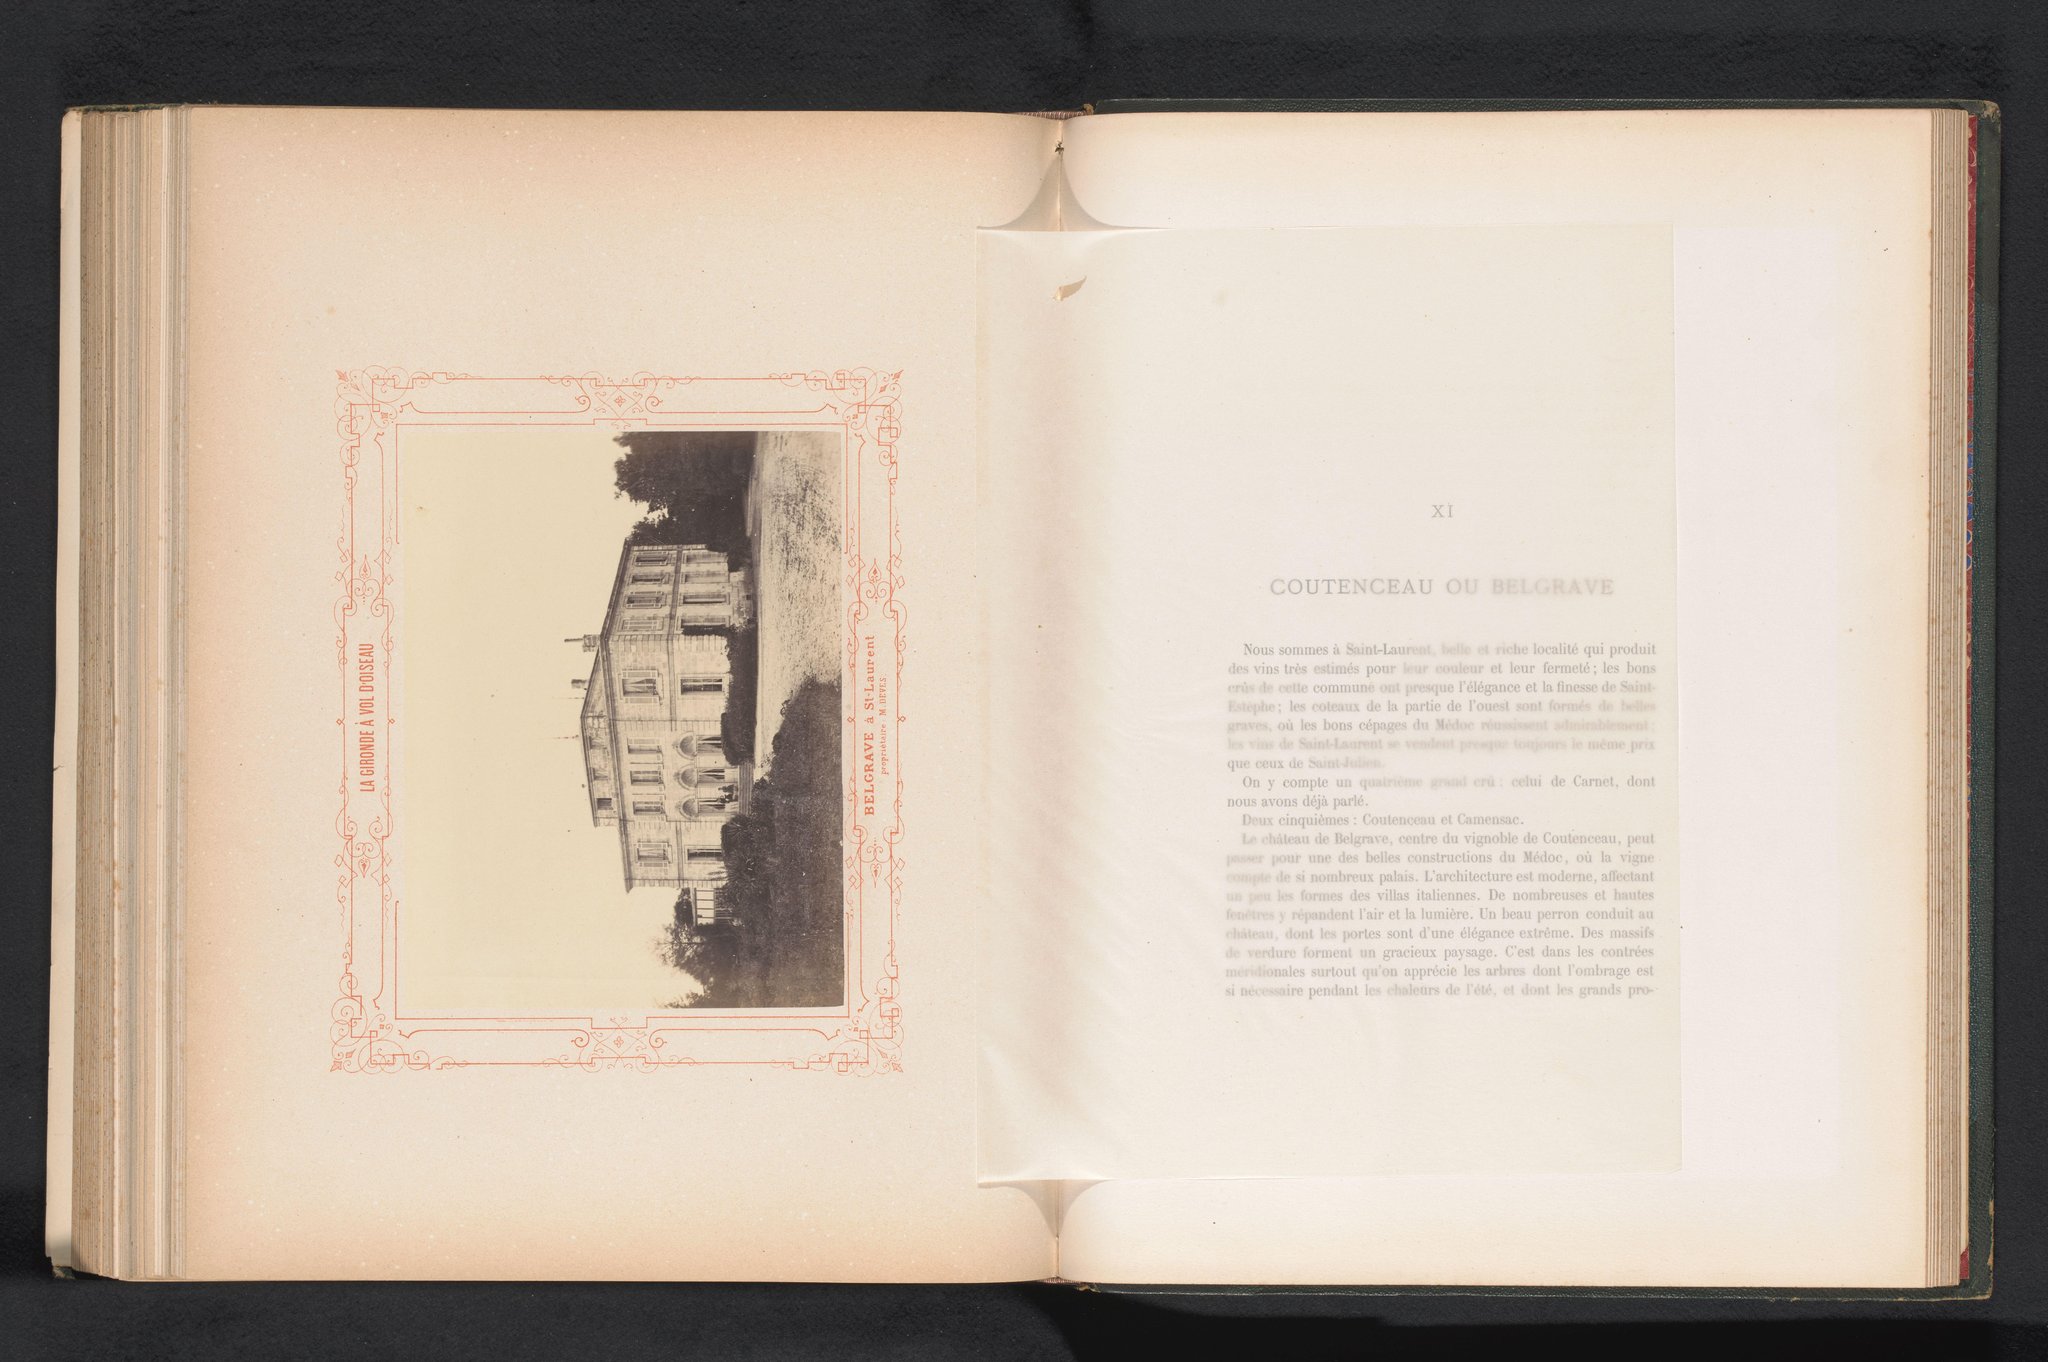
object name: photograph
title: Gezicht op Château Belgrave in Saint-Laurent, Frankrijk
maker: alfred danflou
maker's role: fotograaf, schrijver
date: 1862-1867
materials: photographic support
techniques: albumen print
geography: saint-laurent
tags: castle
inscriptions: inscription: ‘propriétaire: M. DEVES.’